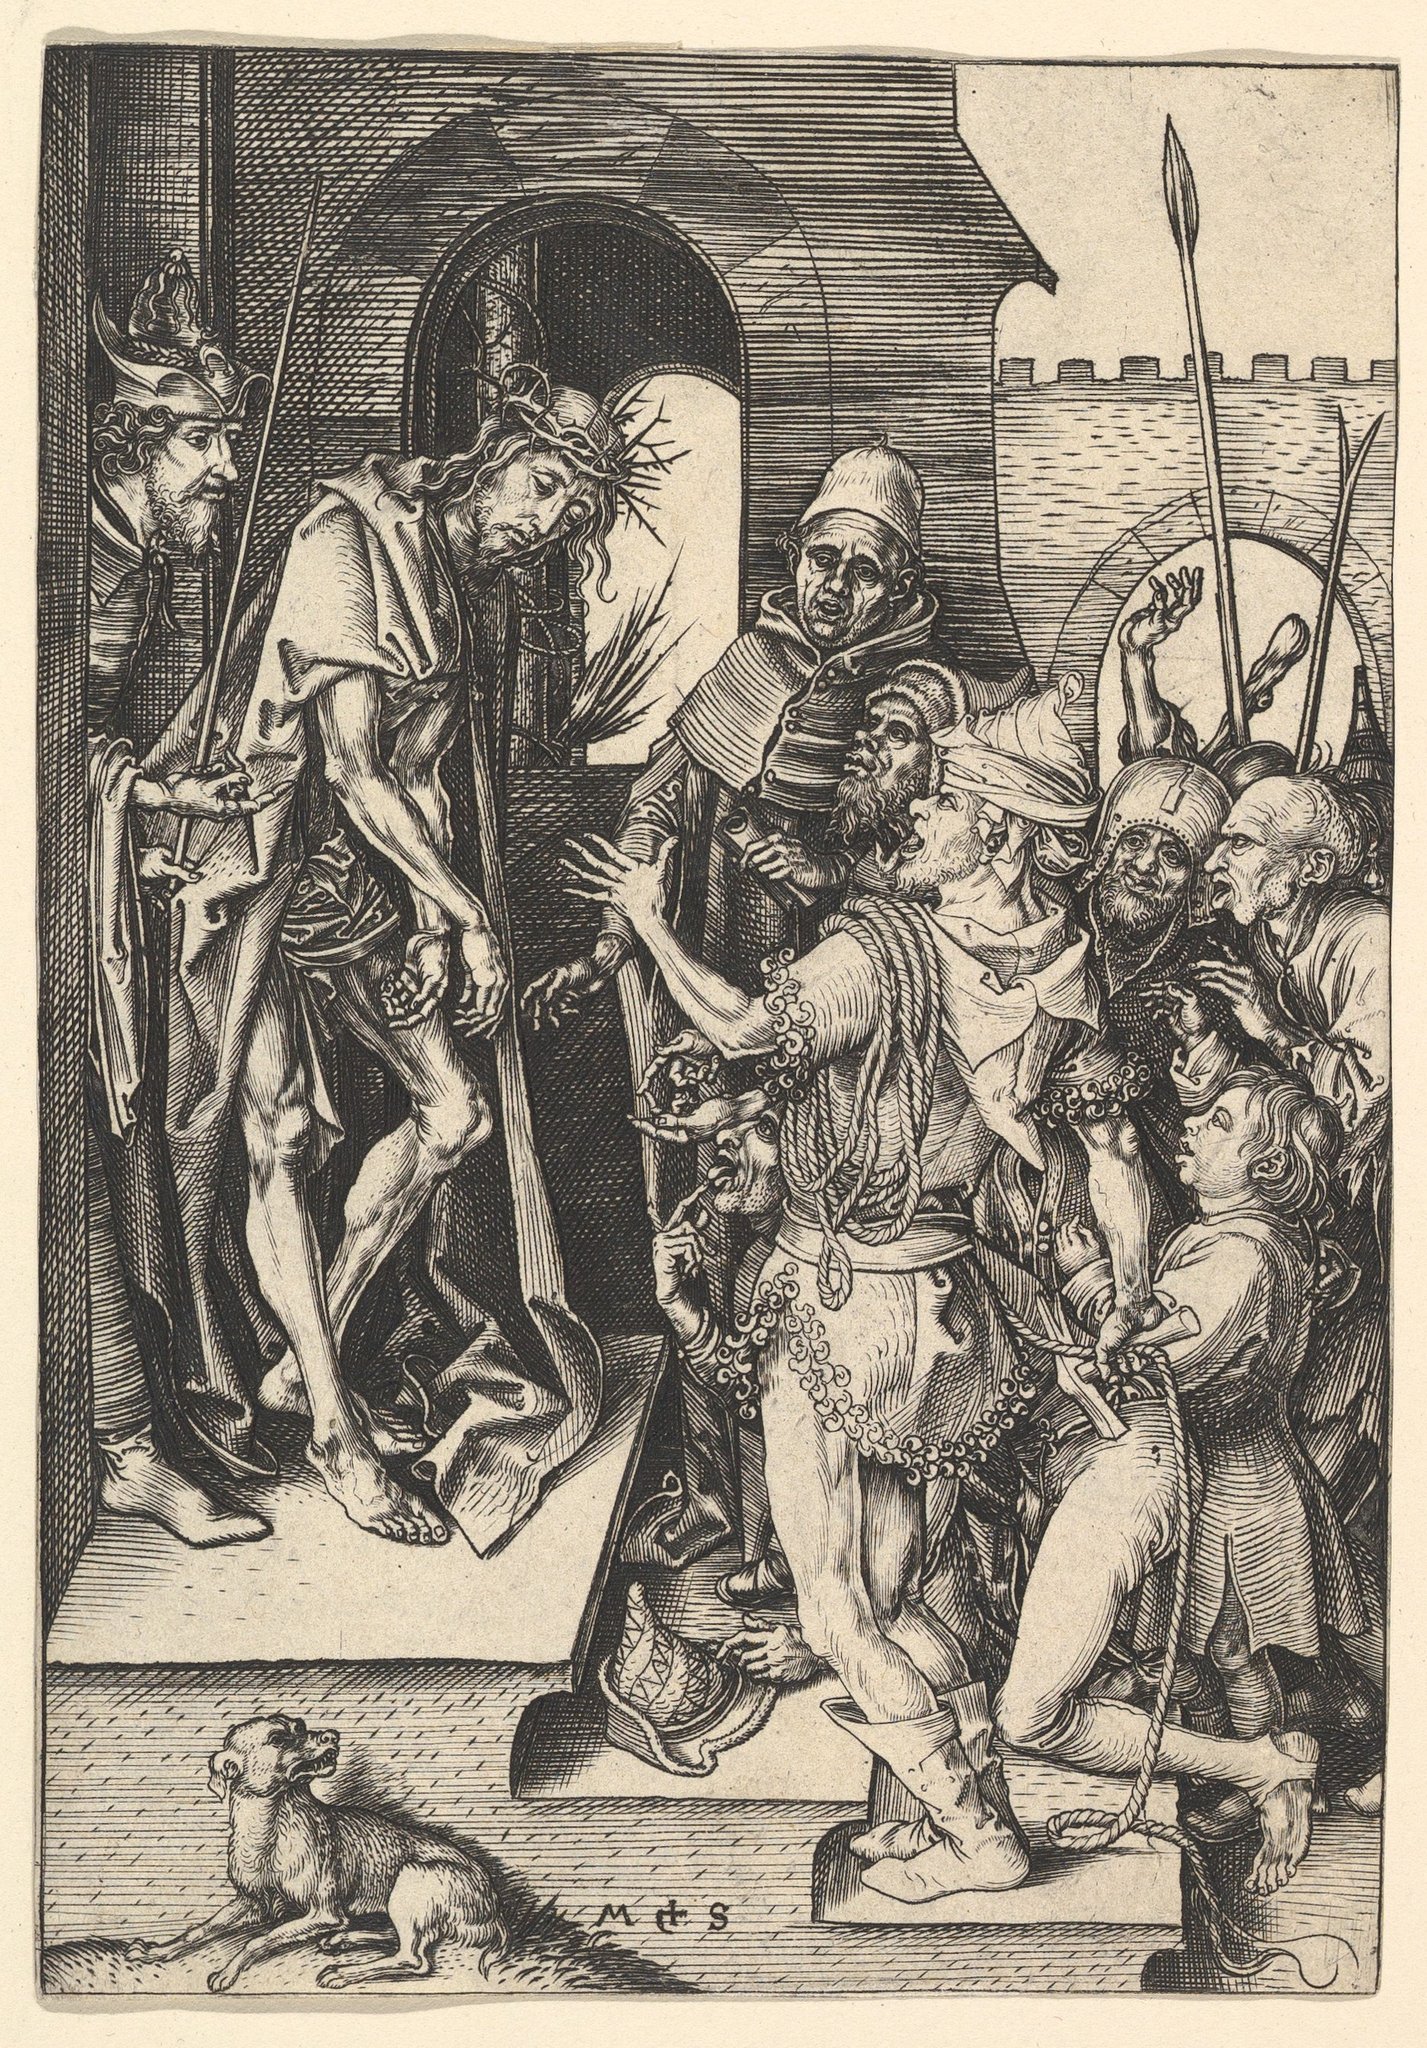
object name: print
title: Ecce Homo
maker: martin schongauer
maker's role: artist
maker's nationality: german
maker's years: 1430-1491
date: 1470-1482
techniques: engraving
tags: spears,men,dogs,jesus